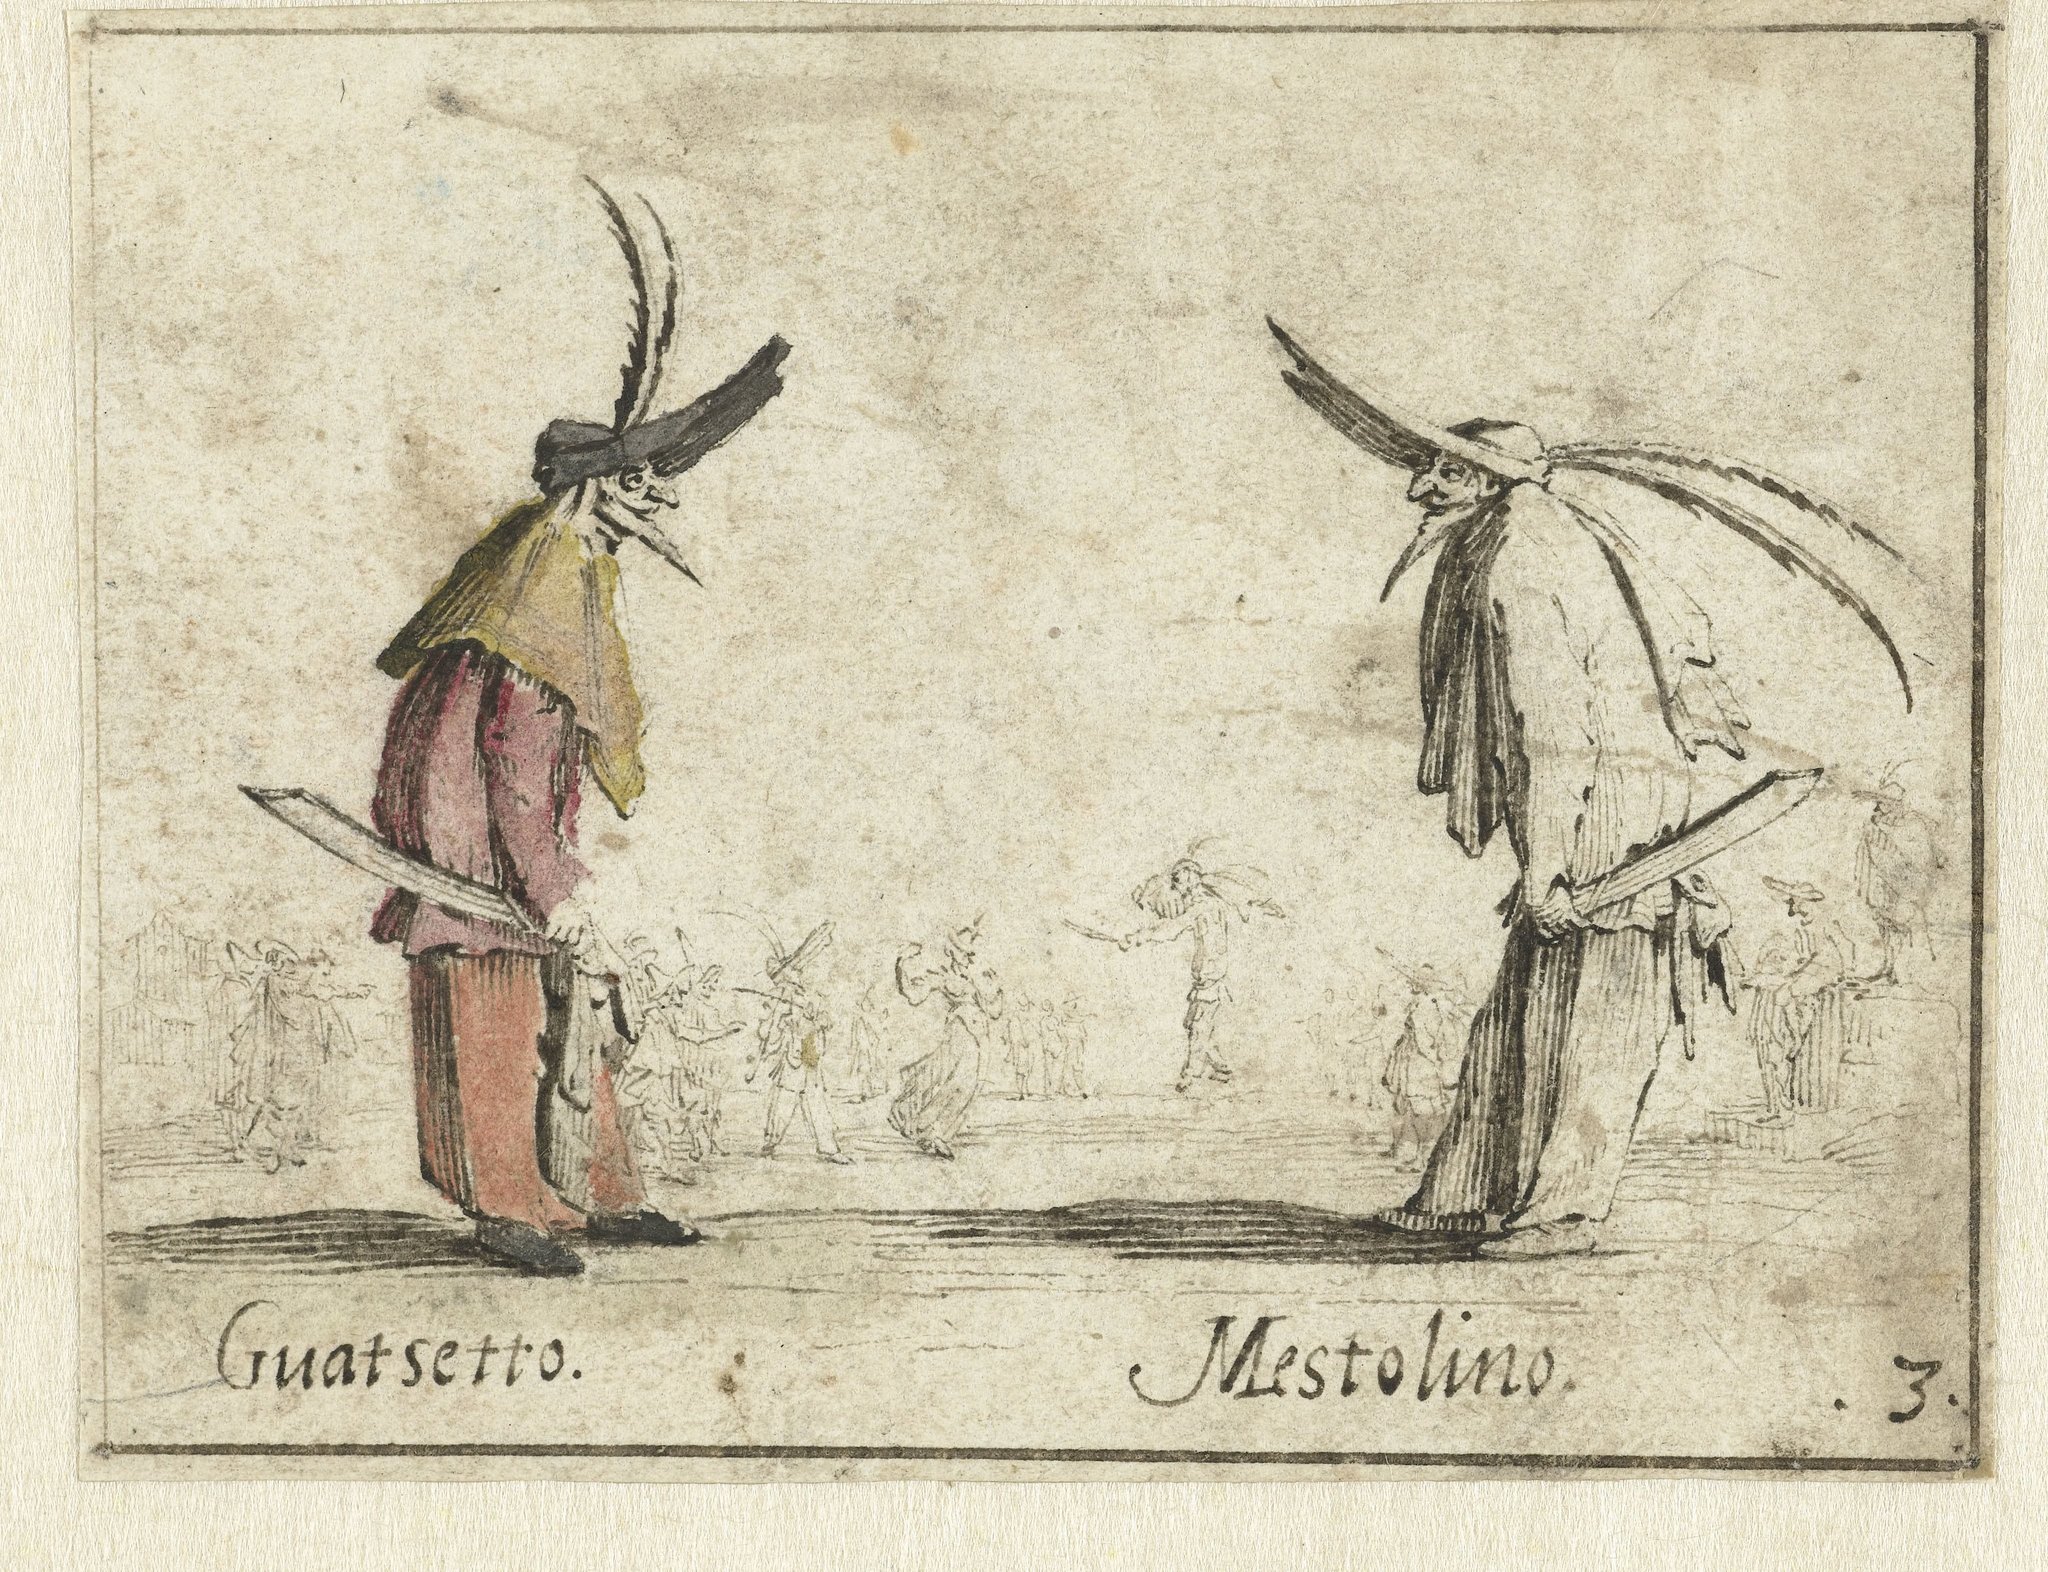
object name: drawing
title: Guatsetto. Mestolino.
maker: gerard ter borch (ii)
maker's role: draughtsman, painter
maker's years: 1617-1681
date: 1633-1635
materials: ink, paper, watercolor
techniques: brush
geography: zwolle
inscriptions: inscription: ‘3’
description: Guatsetto en Mestolino, naar een van de 24 Commedia dell'arte figuren van Jaques Callot, de Balli di Sfessania (Meaume 647, Lieure 385). Waarschijnlijk was dit een van de bladen van een schetsboek of album, dat Gerard (II) in deze periode maakte, gelet op de nummering, die niet naar Callot's serie verwijst.